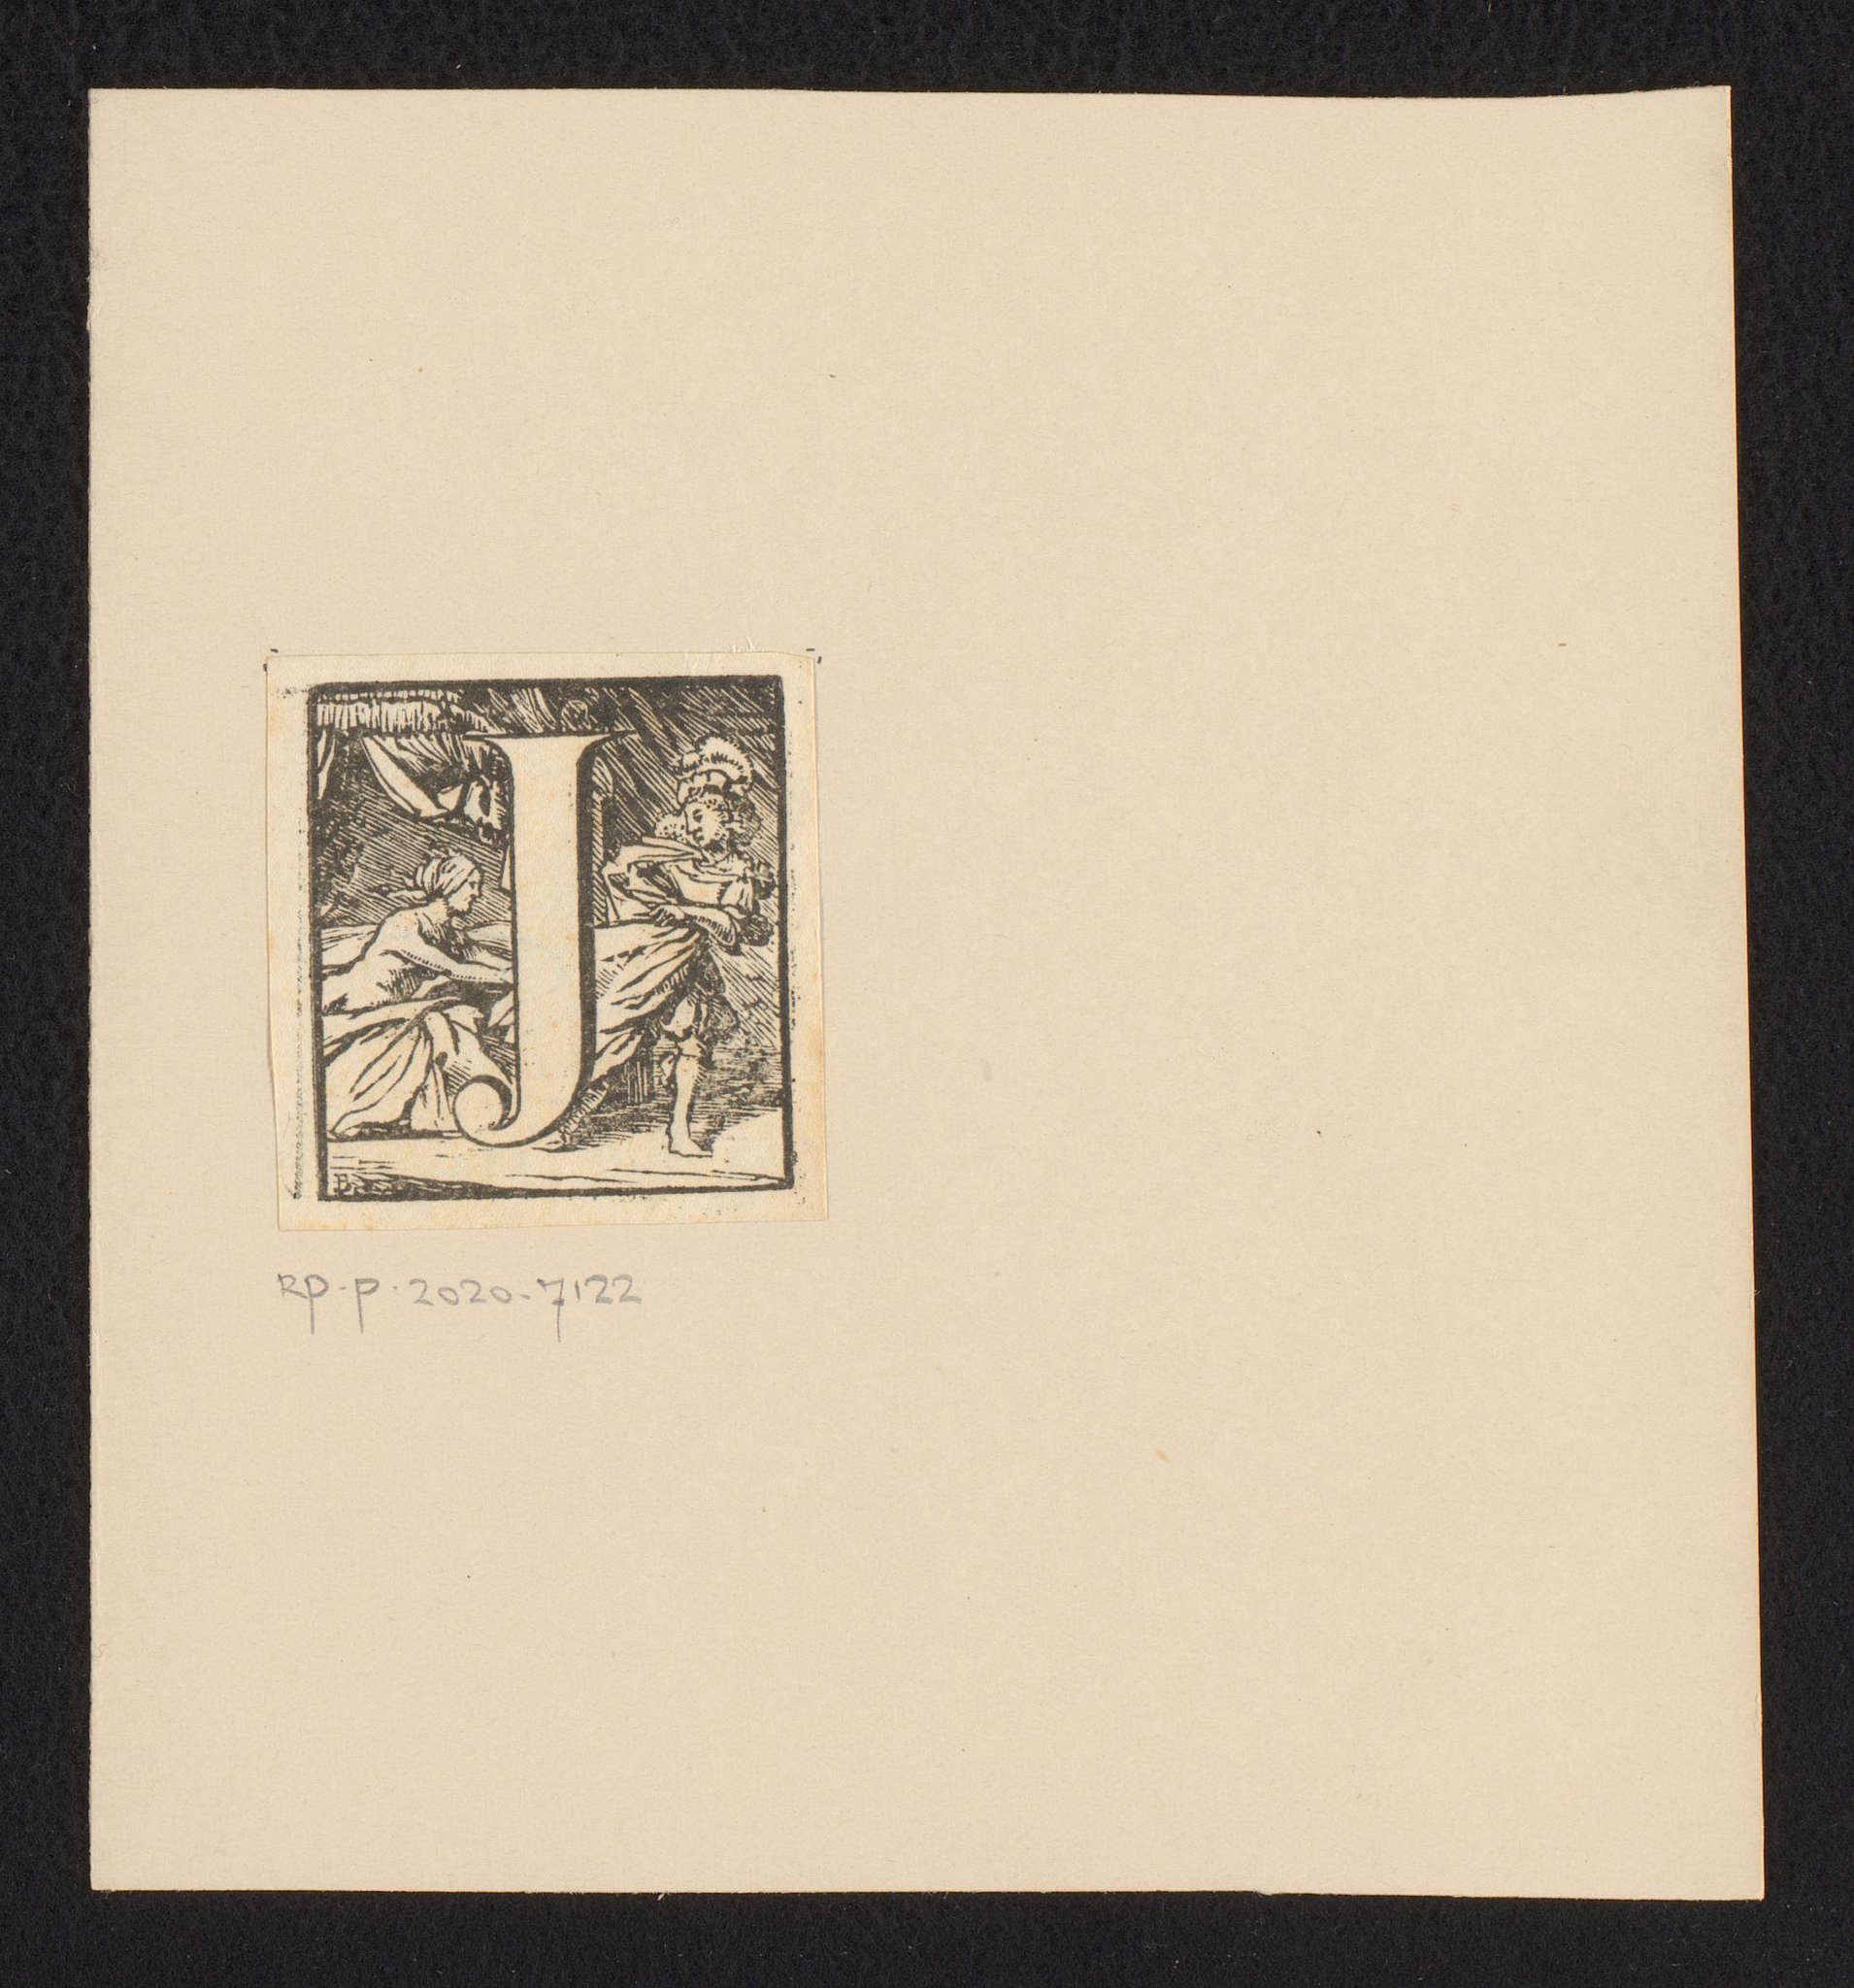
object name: print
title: Gehistorieerde initiaal J met de kuisheid van Jozef als hij vlucht voor de vrouw van Potifar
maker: dirck de bray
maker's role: draughtsman, painter, print maker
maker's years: 1625-1694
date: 1635-1694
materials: paper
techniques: woodcut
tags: potiphar's wife catches joseph by his robe, usually while lying in bed; joseph escapes leaving his cloak behind in her hands (possibly with a naked child lying in a crib), historiated initial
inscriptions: collector's mark: Lugt 2228, collector's mark: Lugt 698